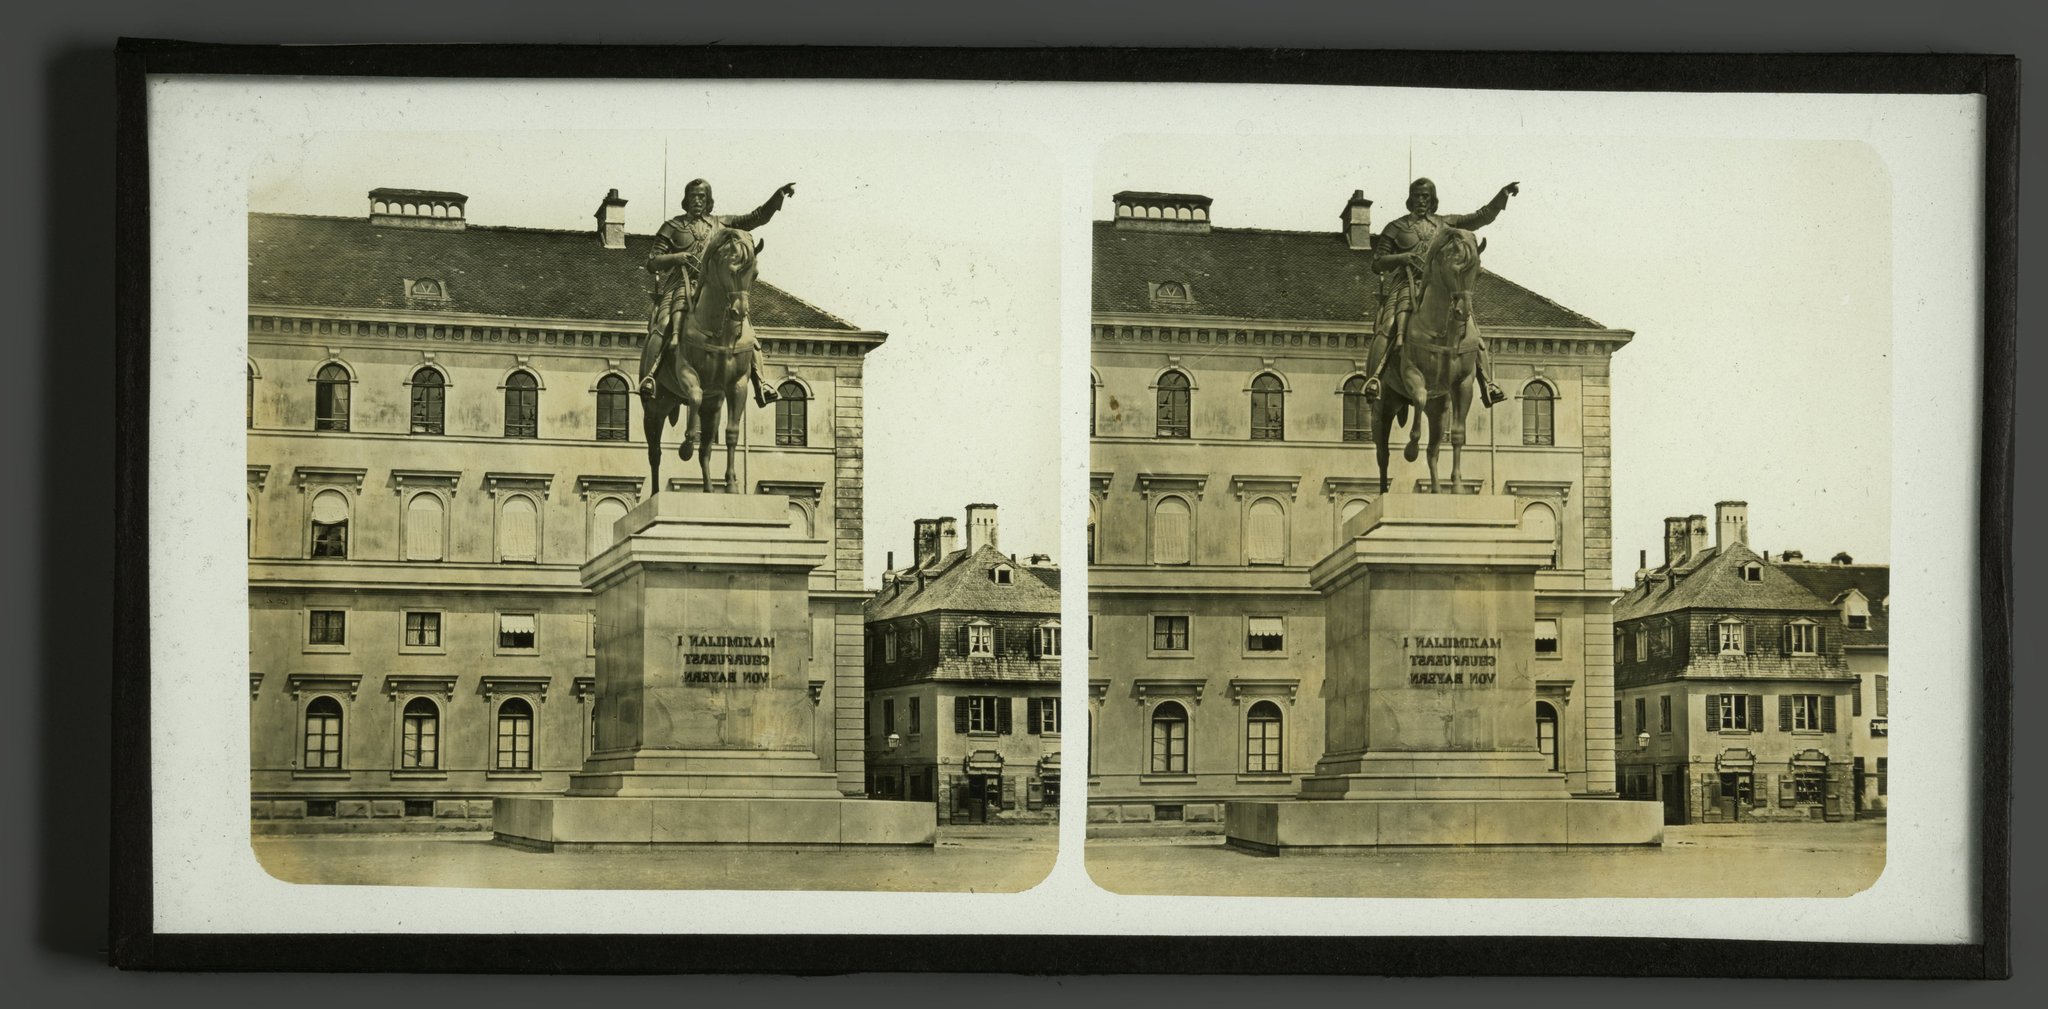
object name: photograph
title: Ruiterstandbeeld van Maximiliaan I van Beieren op het Wittelsbacherplatz in München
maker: Anonymous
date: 1860-1890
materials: glass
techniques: slide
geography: munich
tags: maximiliaan i (keurvorst van beieren), monument, statue